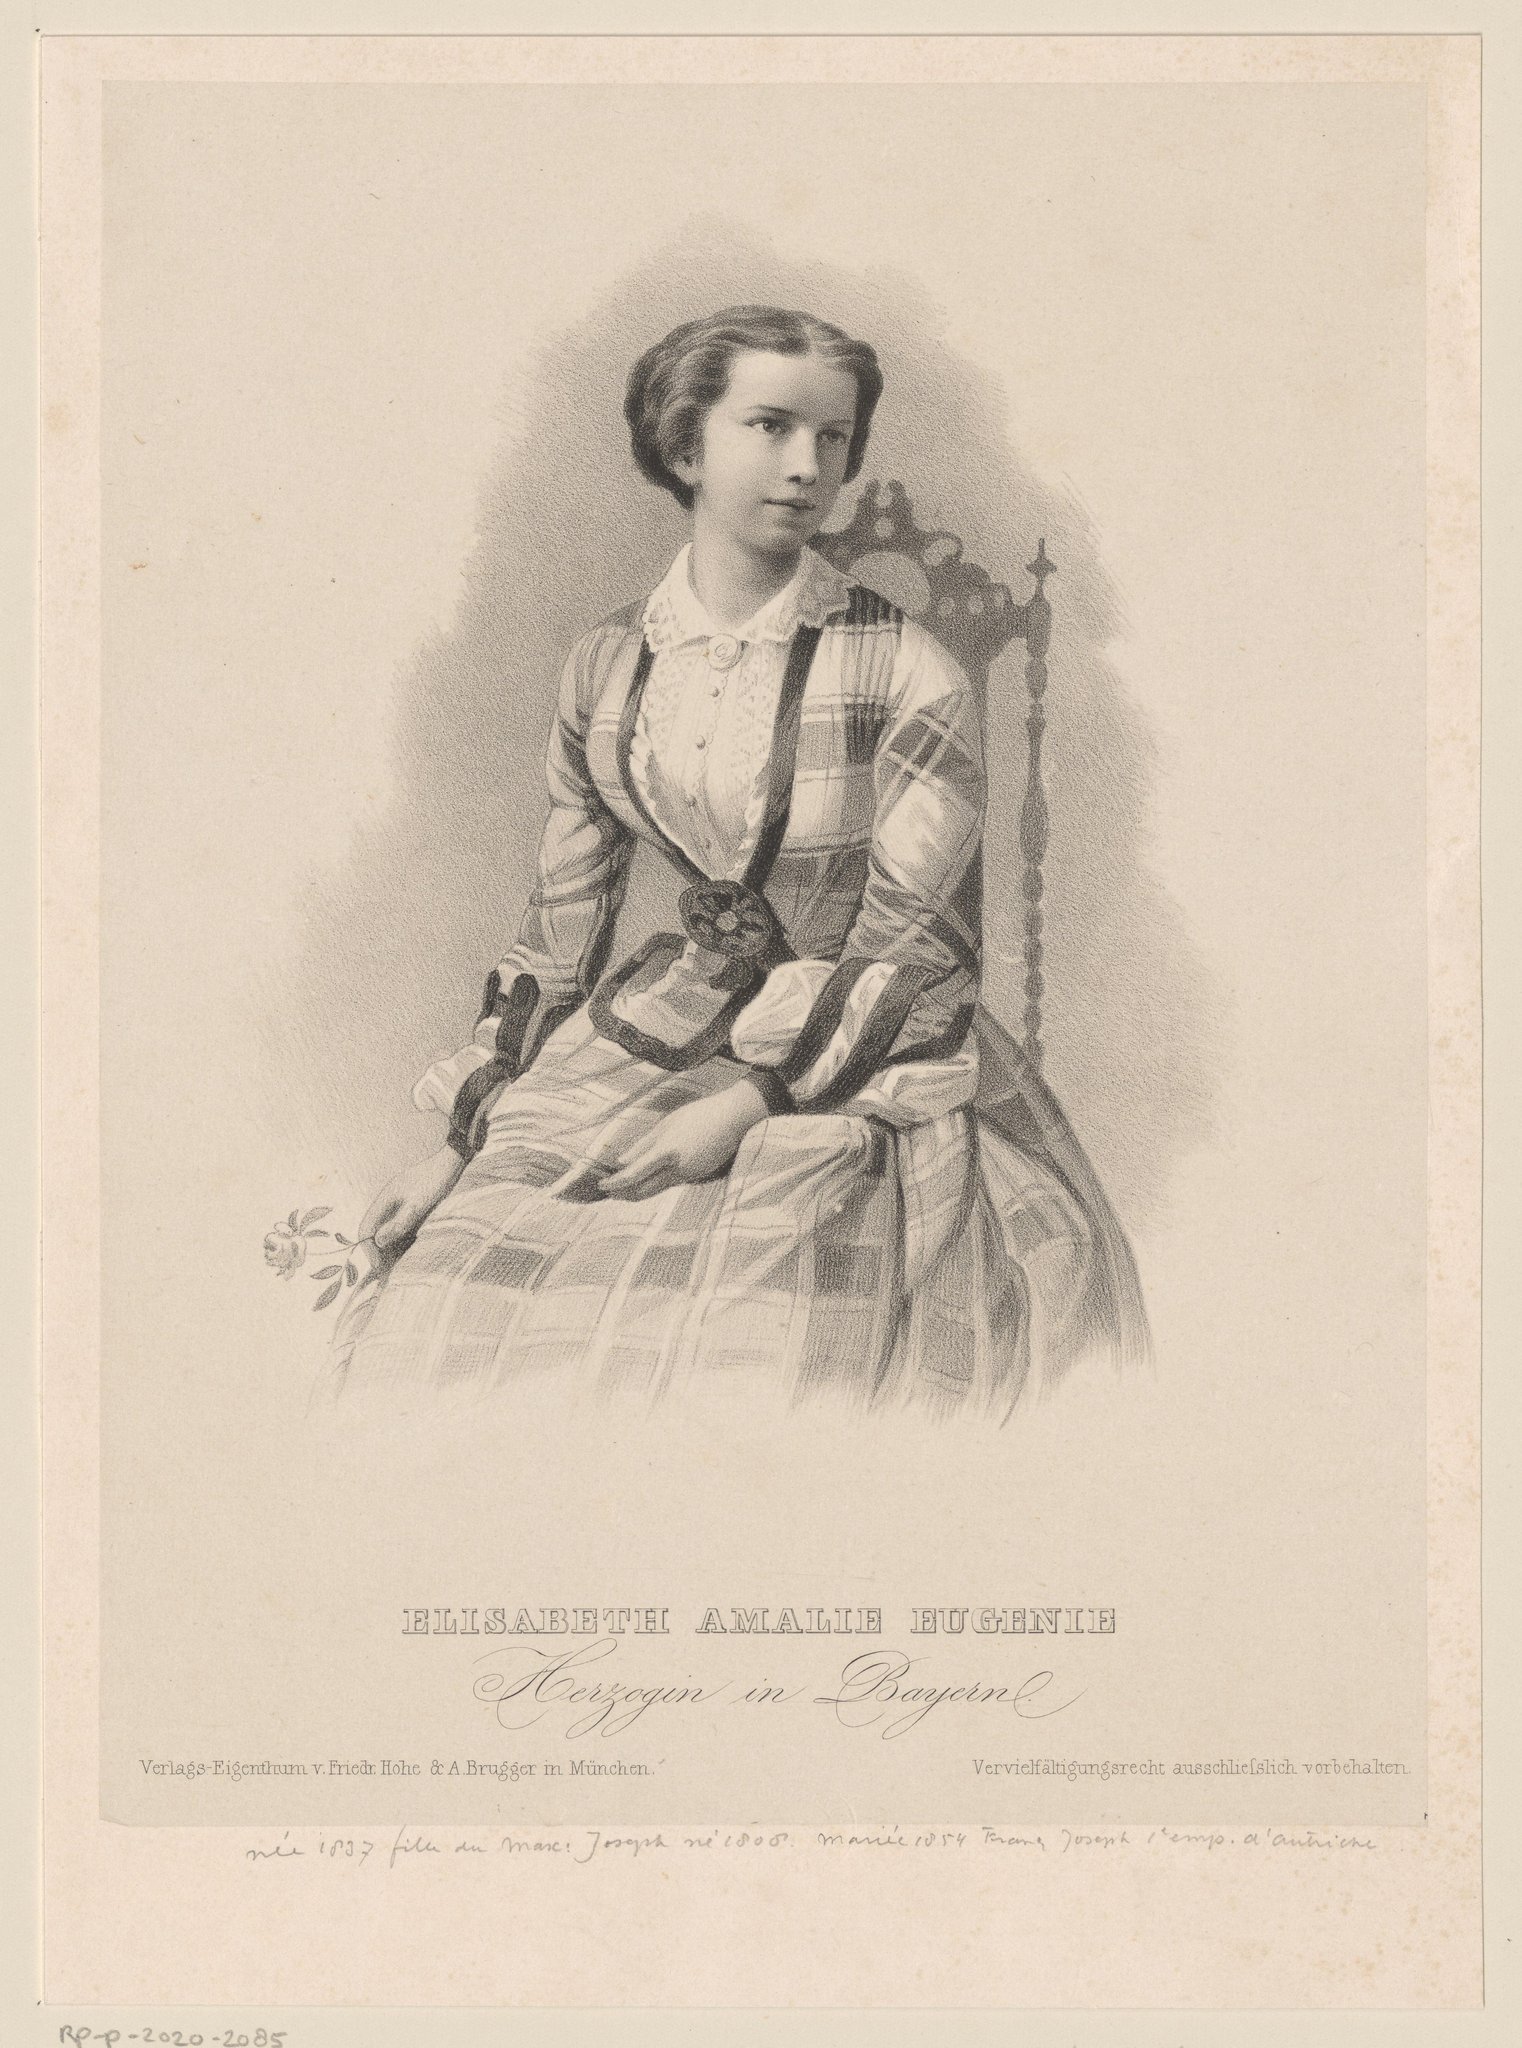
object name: print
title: Portret van Elisabeth in Beieren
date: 1850-1854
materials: paper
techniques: lithograph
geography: munich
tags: historical persons - bb - woman